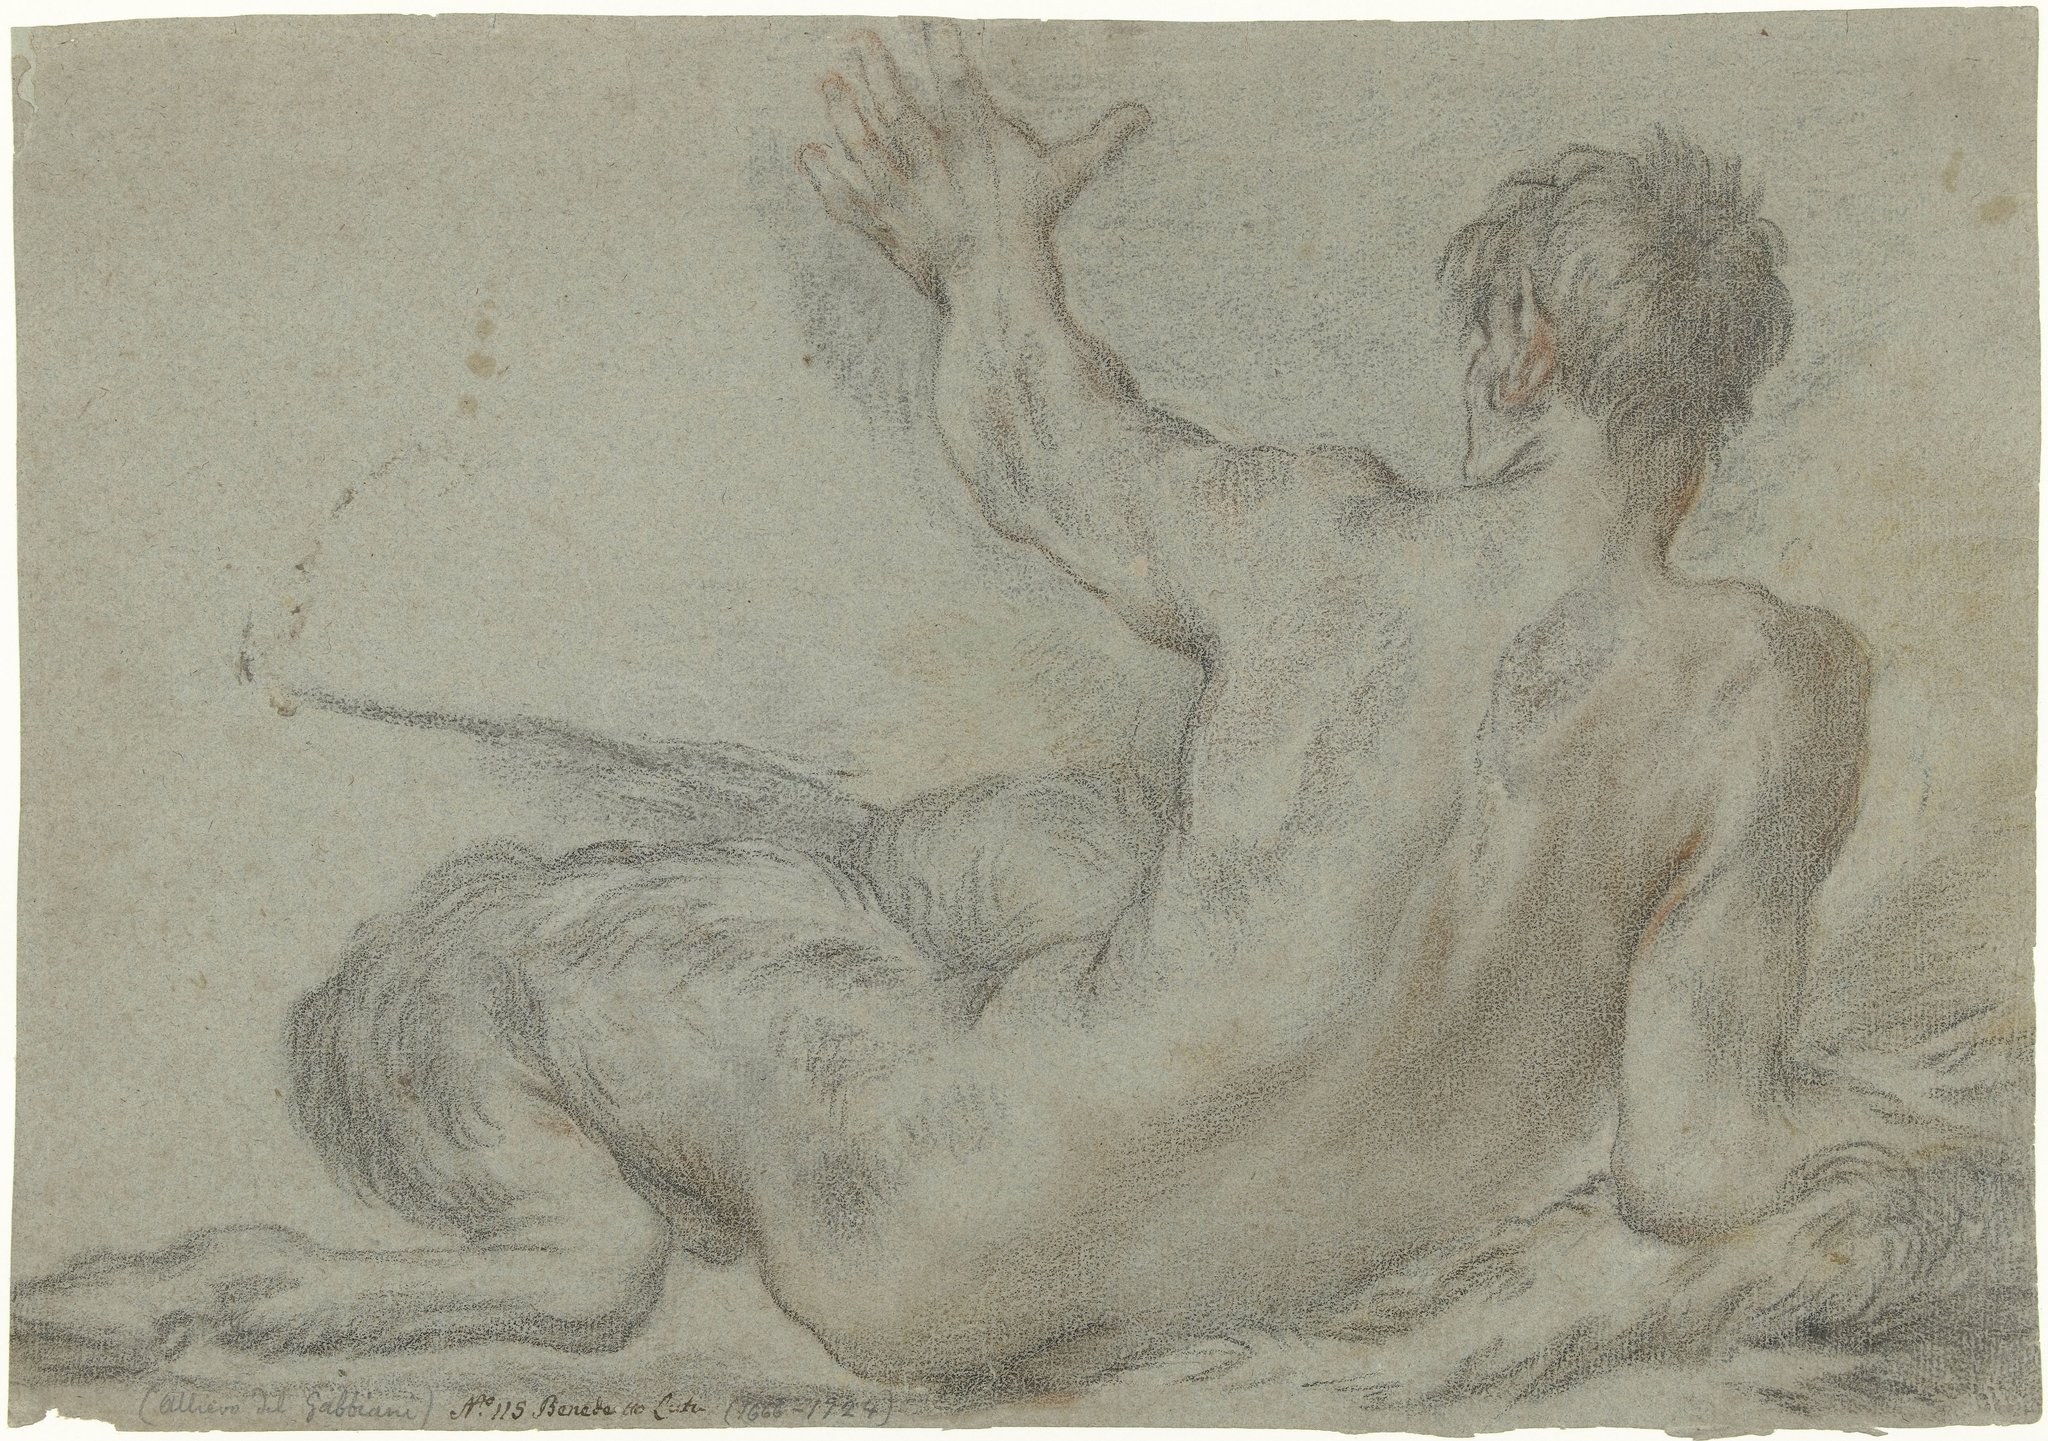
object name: drawing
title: Liggende sater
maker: benedetto luti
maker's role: draughtsman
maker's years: 1666-1724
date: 1676-1724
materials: chalk, paper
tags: satyr(s) (in general)